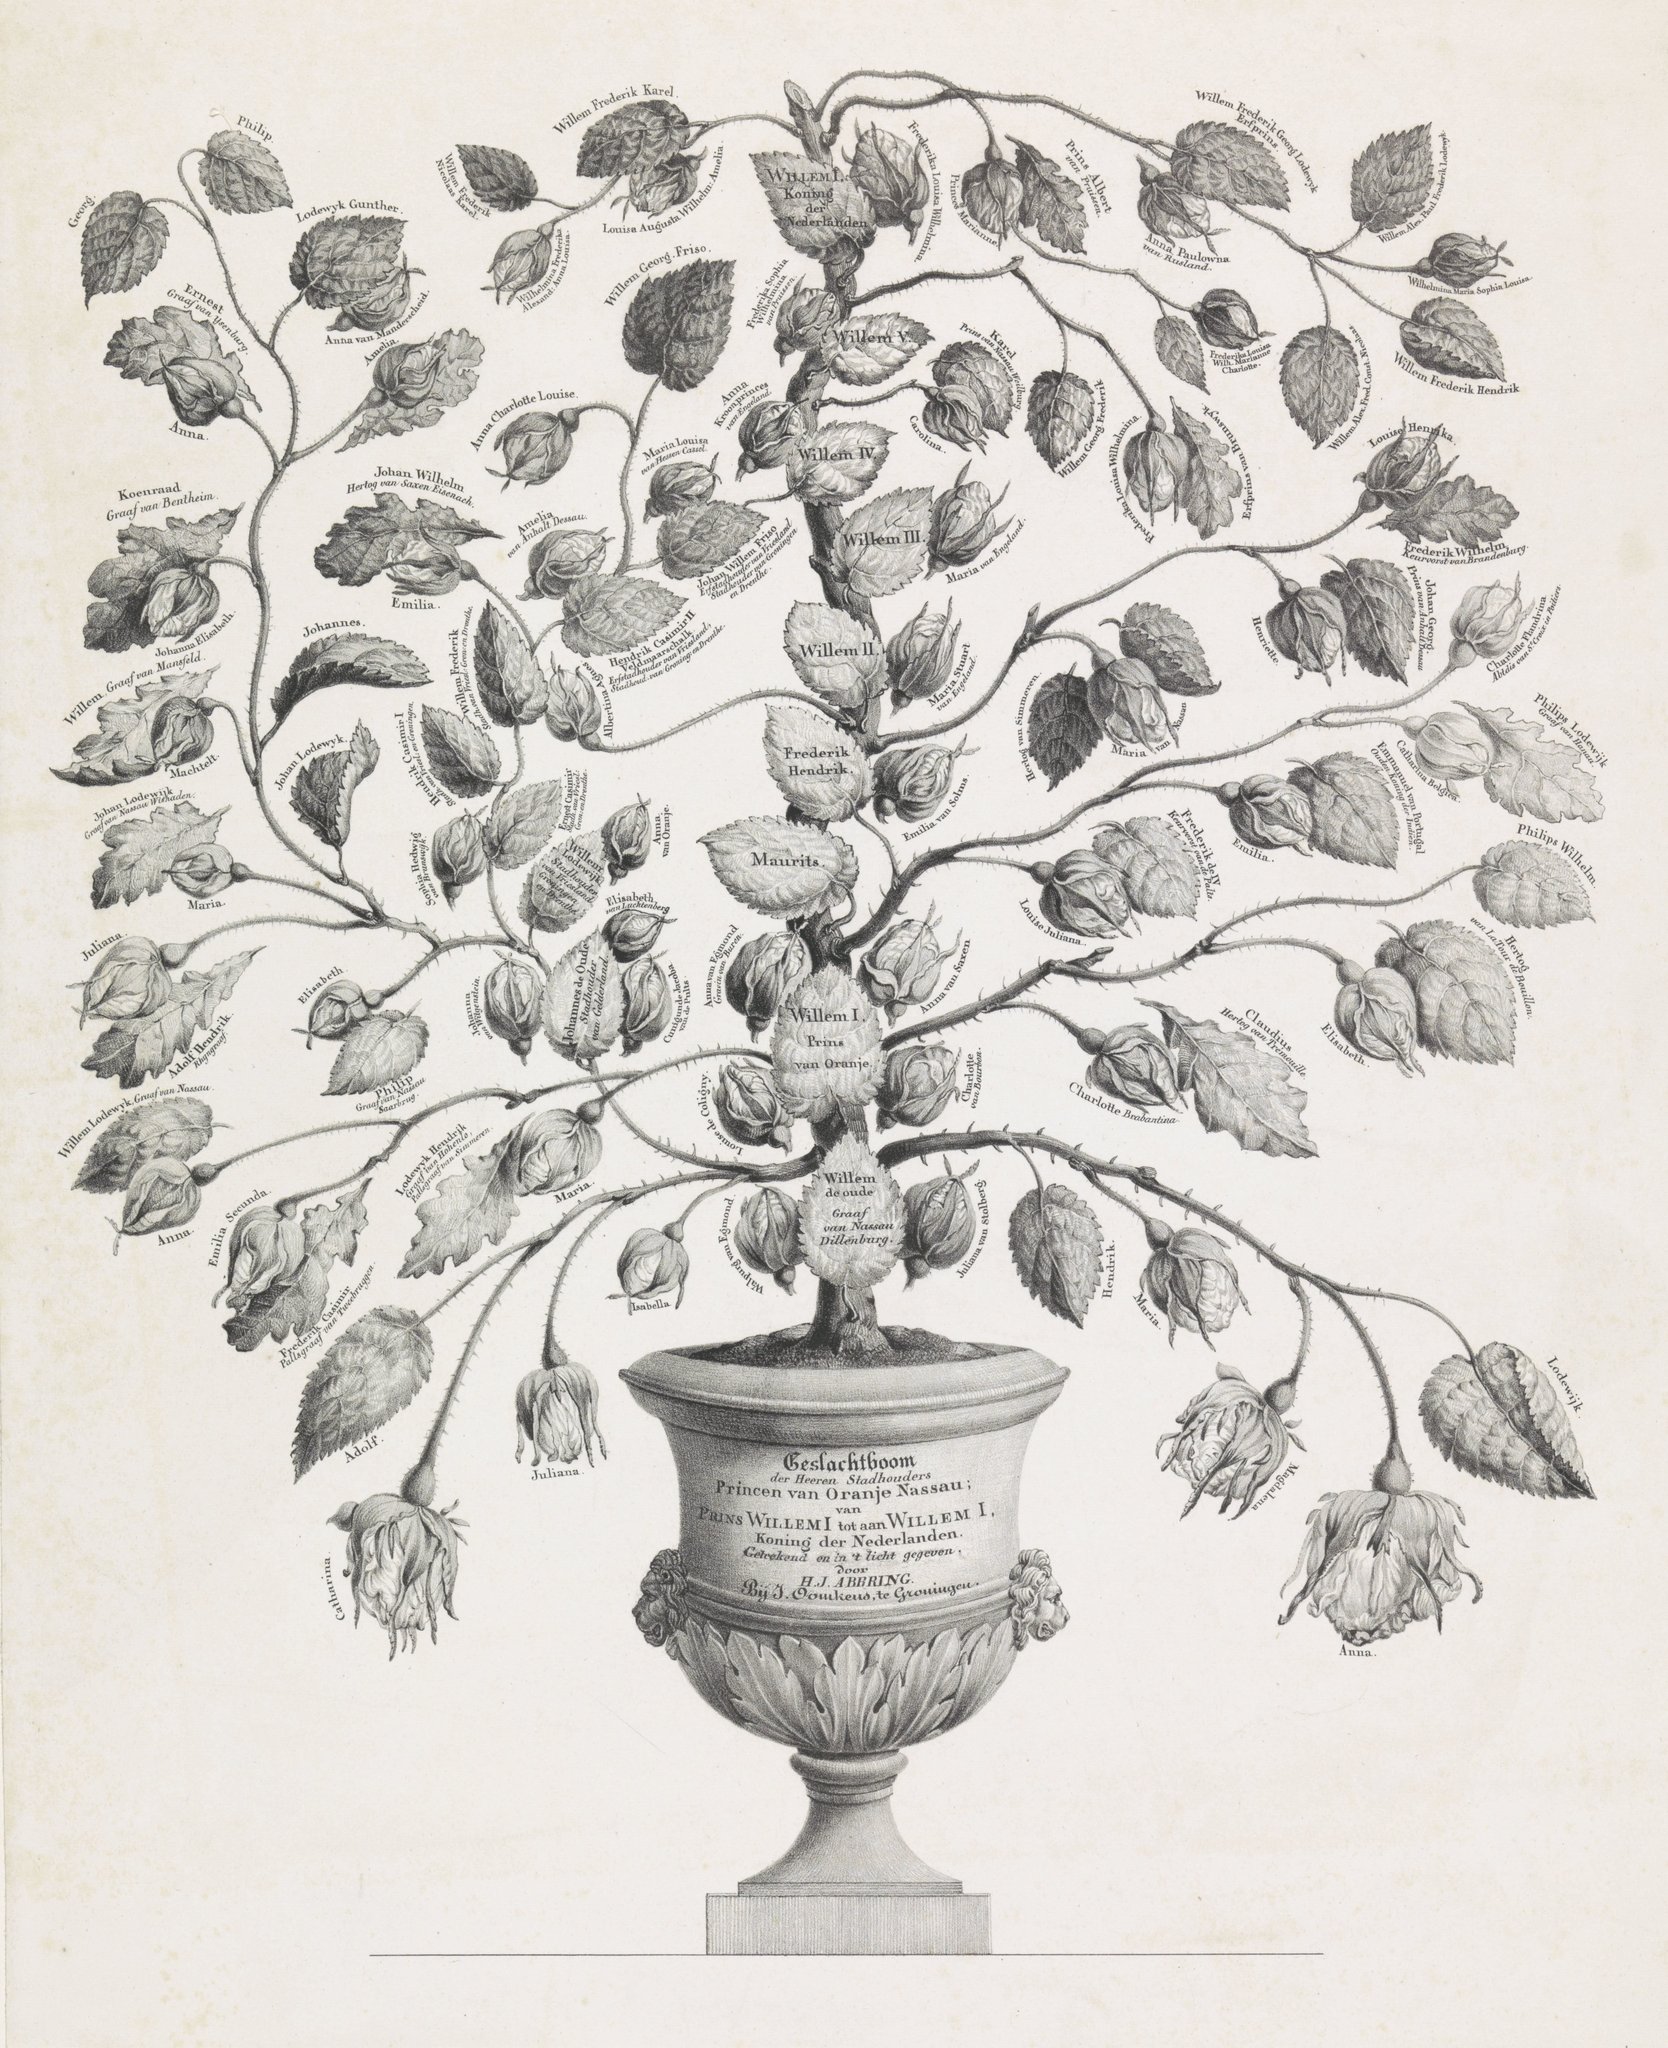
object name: print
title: Stamboom van koning Willem I, ca. 1835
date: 1833-1836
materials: paper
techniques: lithograph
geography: netherlands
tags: the hague, william i of the netherlands, family lineage, pedigree, genealogical tree or table, shrubs: rose-bush, flowers: rose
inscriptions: collector's mark: Lugt 2228, collector's mark: Lugt 2760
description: Stamboom van koning Willem I, ca. 1835, in de vorm van een rozenstruik in een pot. De centrale stam lopend vanaf Willem de Oude, graaf van Nassau, tot aan koning Willem I. De jongste telgen aan deze struik zijn Willem, het tweede kind uit het huwelijk van Willem Frederik Karel met Louise van Pruisen, geboren in 1833 en overleden in 1834. Het eerstvolgende kind, Frederik, geboren in 1836, ook een kind van Willem Frederik Karel en Louise van Pruisen is niet in de stamboom vermeld.